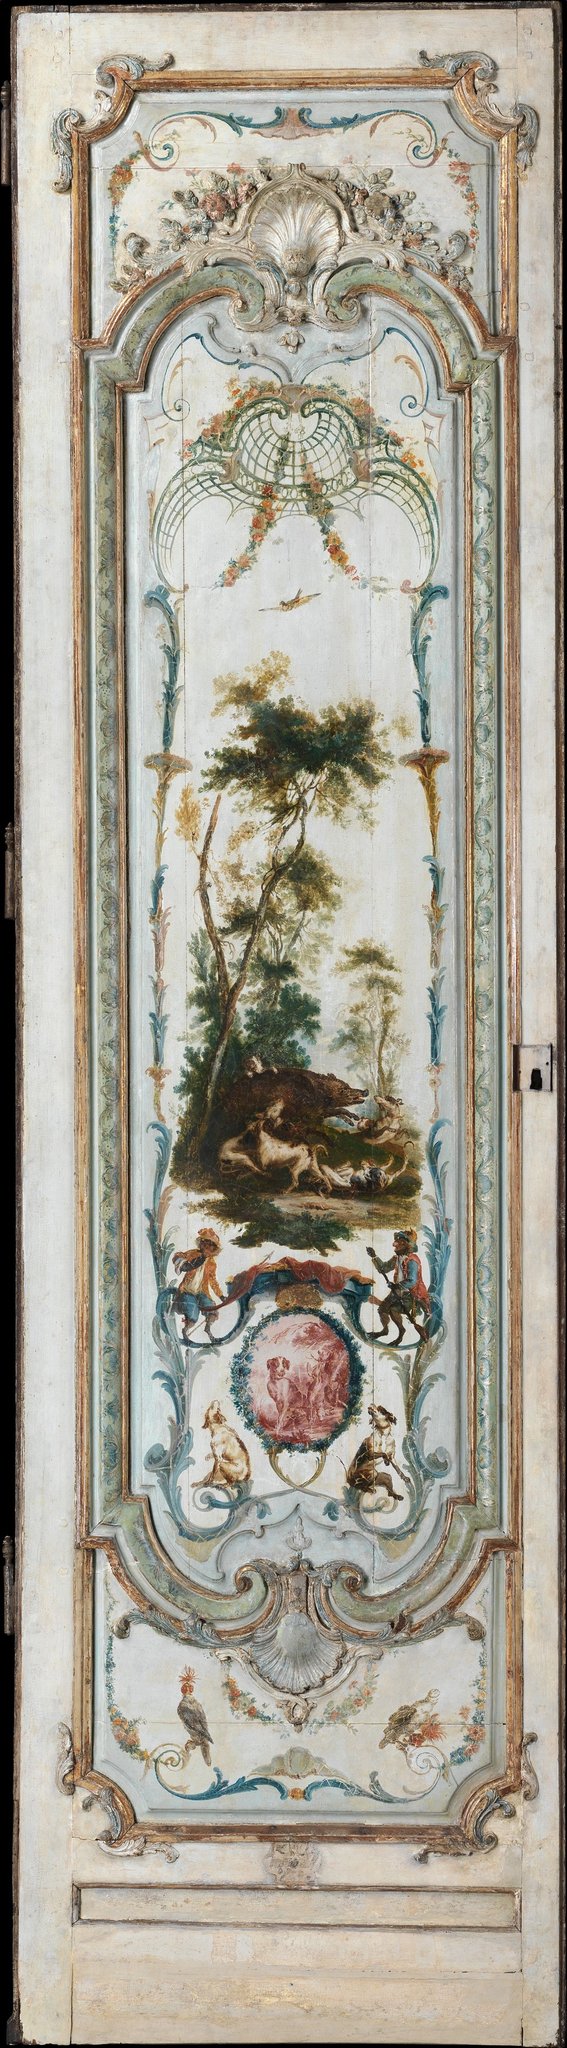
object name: door panel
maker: christophe hüet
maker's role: artist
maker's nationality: french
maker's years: 1700-1759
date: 1751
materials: wood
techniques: gilding, painting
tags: animals,birds,hunting,boars,dogs,monkeys,trees